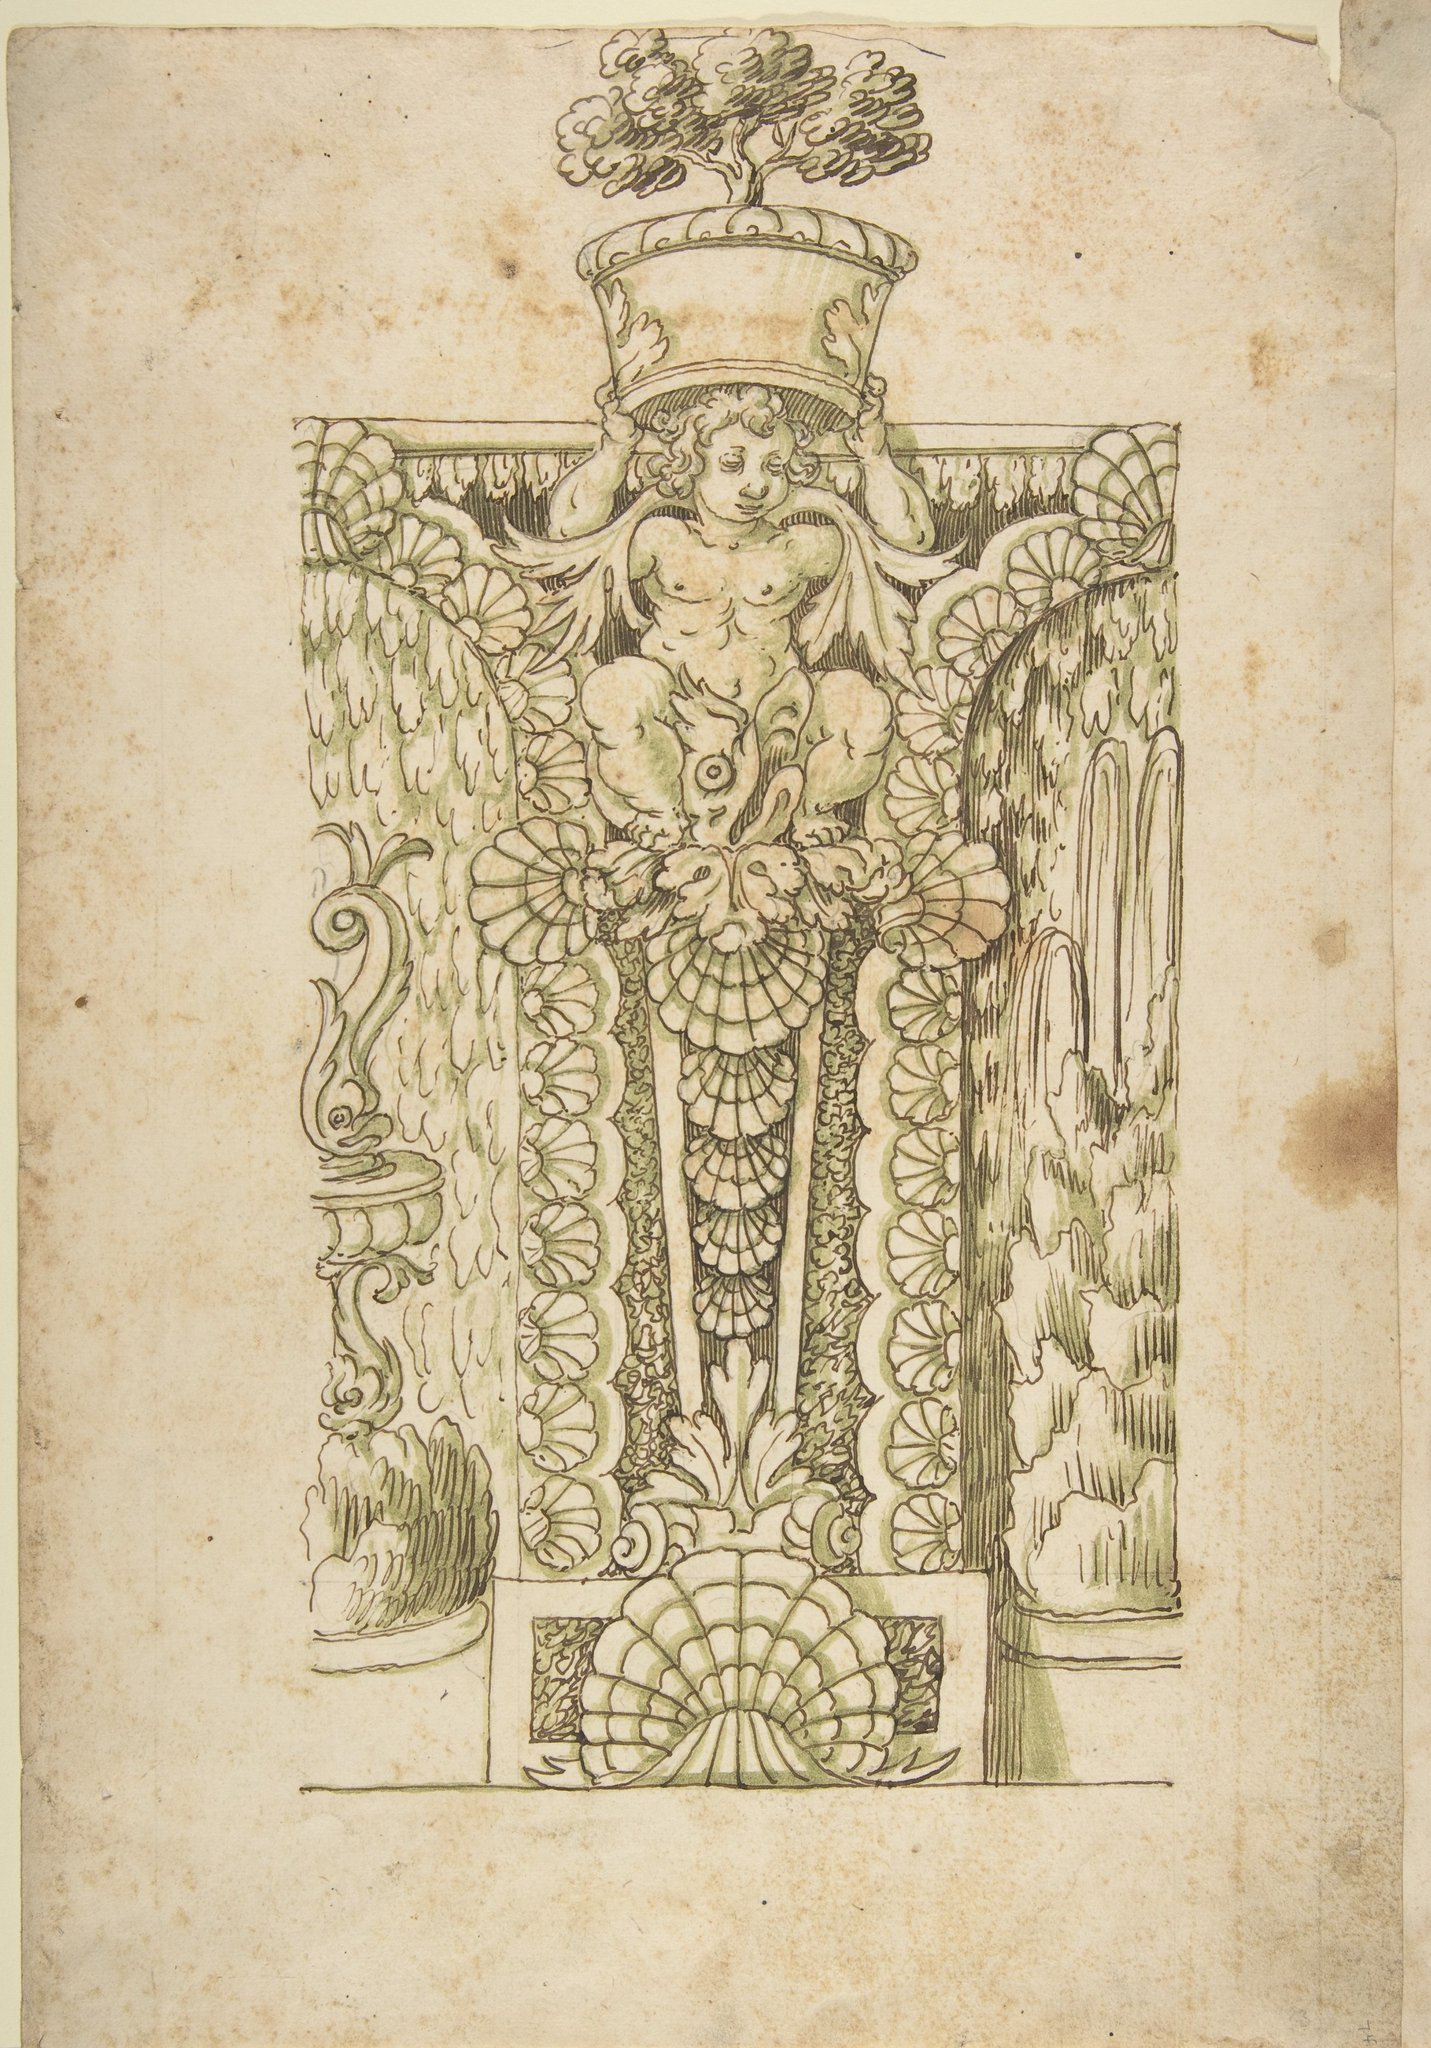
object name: drawing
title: Design for a Wall Fountain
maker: anonymous, italian, lombard, 16th century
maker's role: artist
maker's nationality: italian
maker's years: 1500-1600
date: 1550-1620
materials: graphite, ink, lead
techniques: brush, pen, drawing, wash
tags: fountains,palmettes,plants